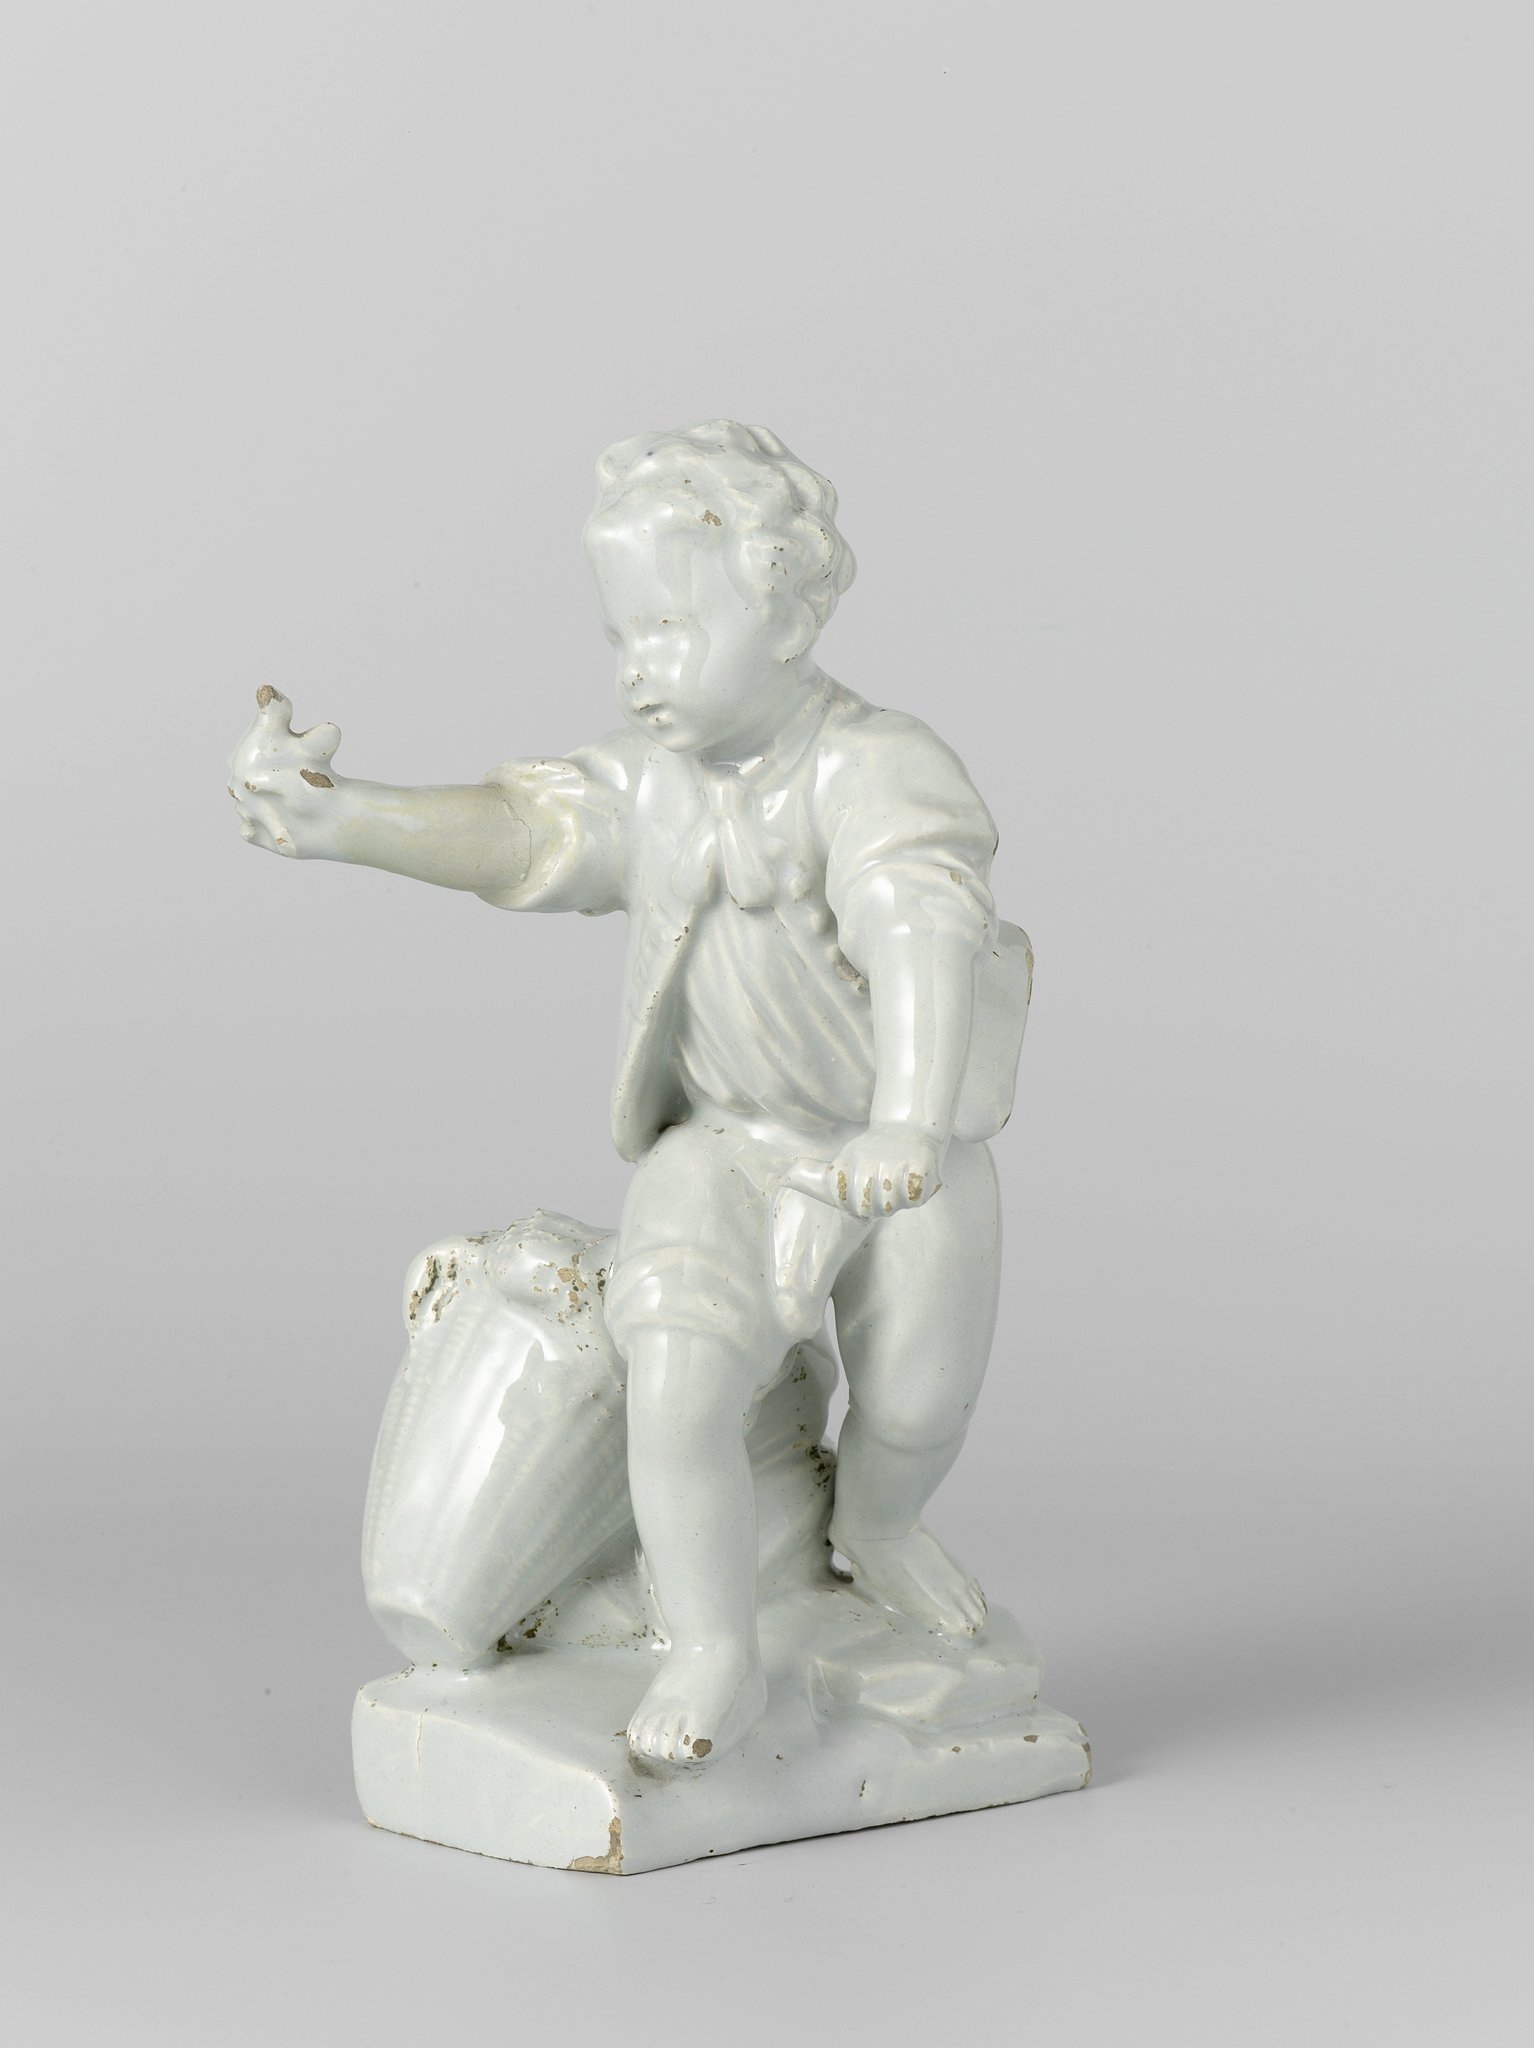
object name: mannenfiguur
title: Herdersfiguur met vogel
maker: Anonymous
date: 1750-1770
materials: faience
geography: delft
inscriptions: collector's mark: ‘5030 A (in zwarte inkt), 321 (in rode en zwarte inkt)’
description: Mannenfiguur van faience, in de vorm van een herder met een vogel. Wit geglazuurd.